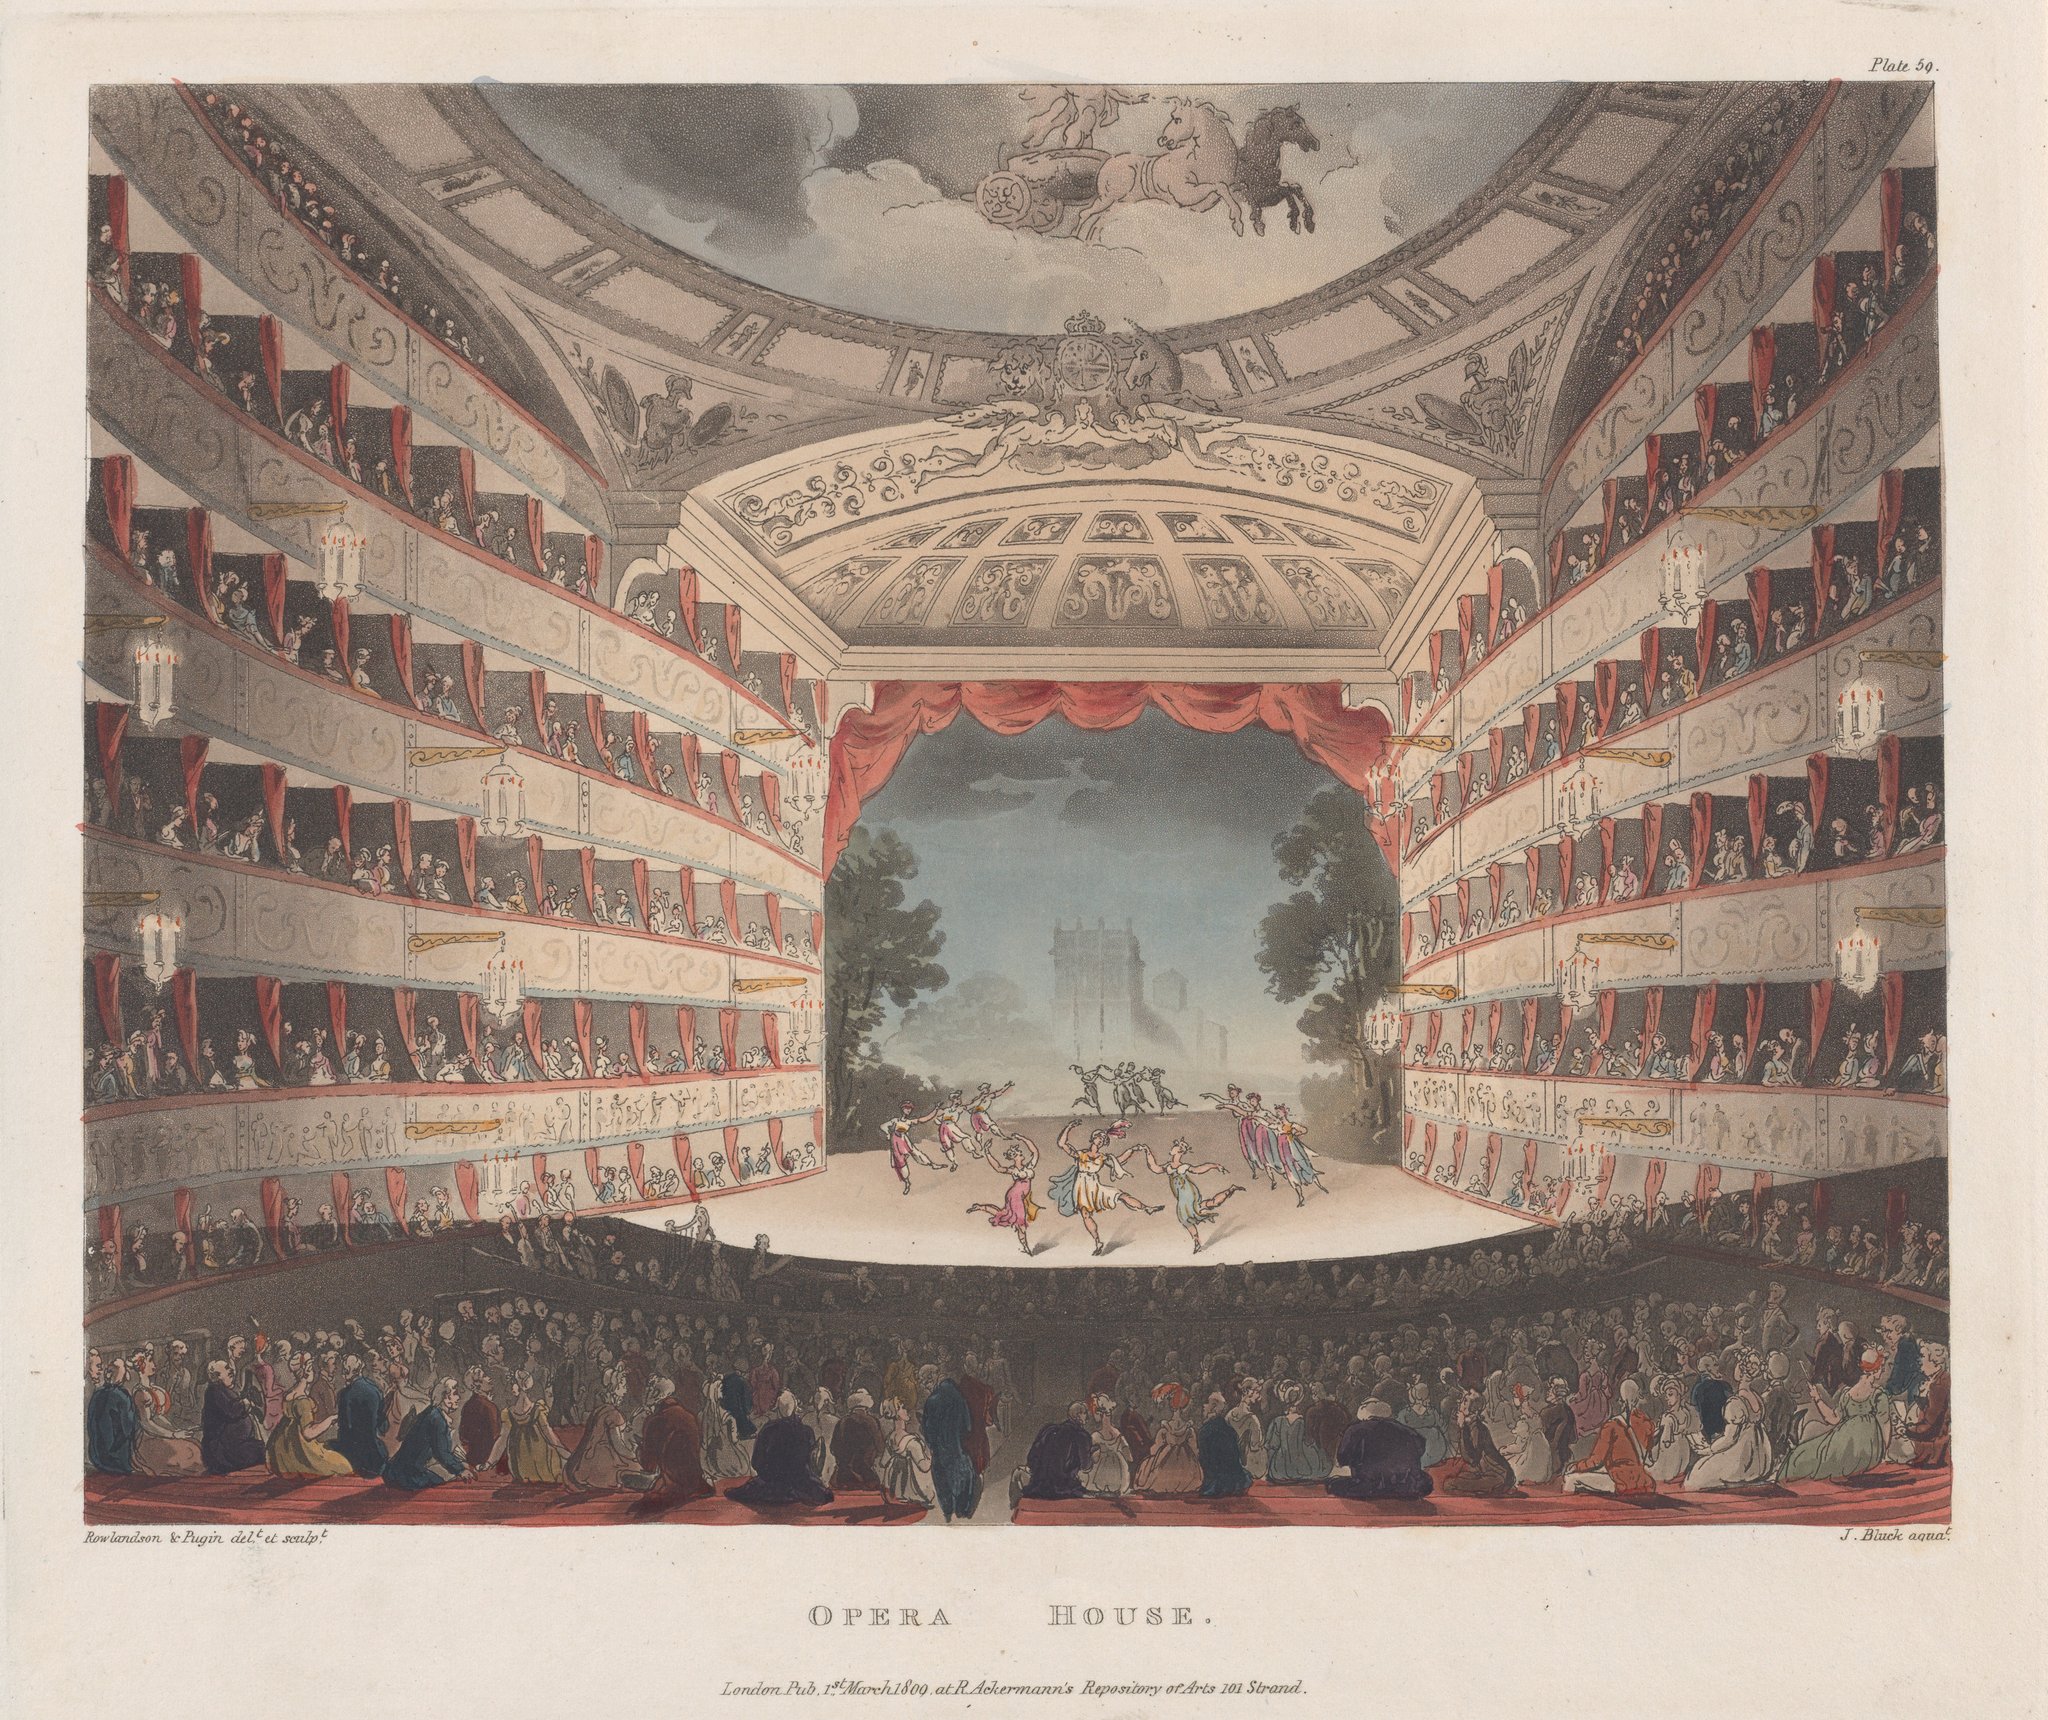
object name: print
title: Opera House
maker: thomas rowlandson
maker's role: artist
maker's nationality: british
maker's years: 1757-1827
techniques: aquatint, etching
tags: opera,performance,theatre,interiors,spectators,dancing